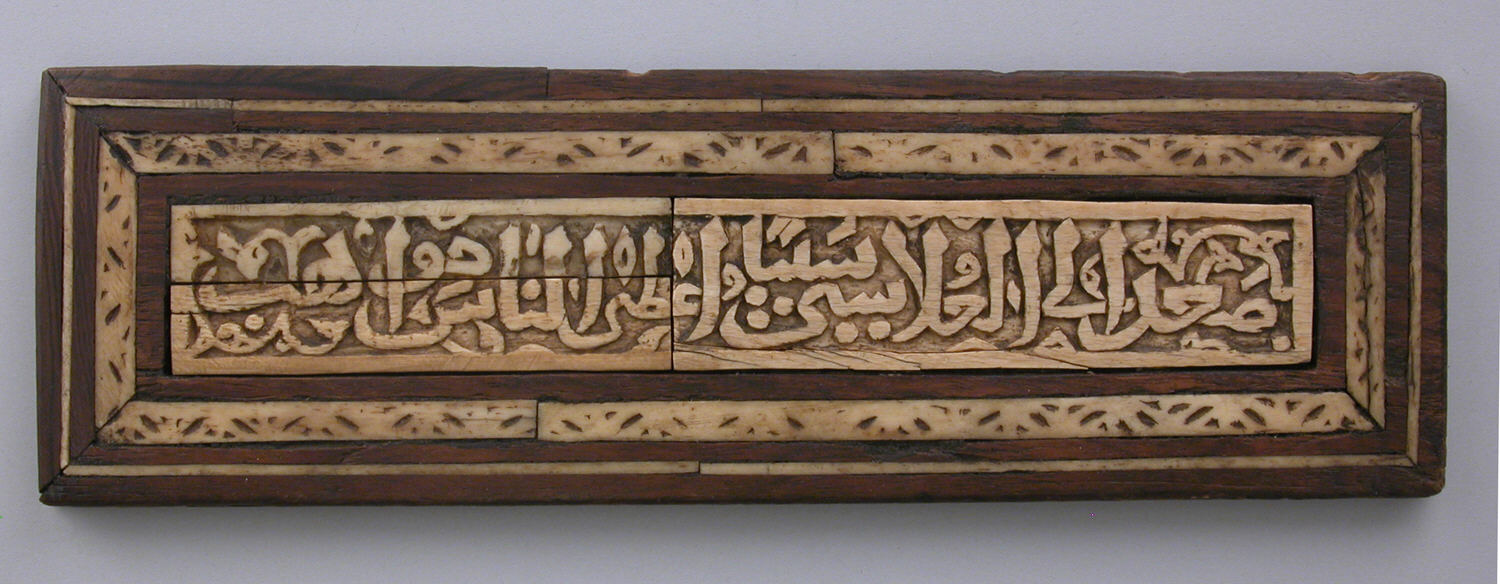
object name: panel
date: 1301-1500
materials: ivory, wood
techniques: carving, inlay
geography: egypt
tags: arabic